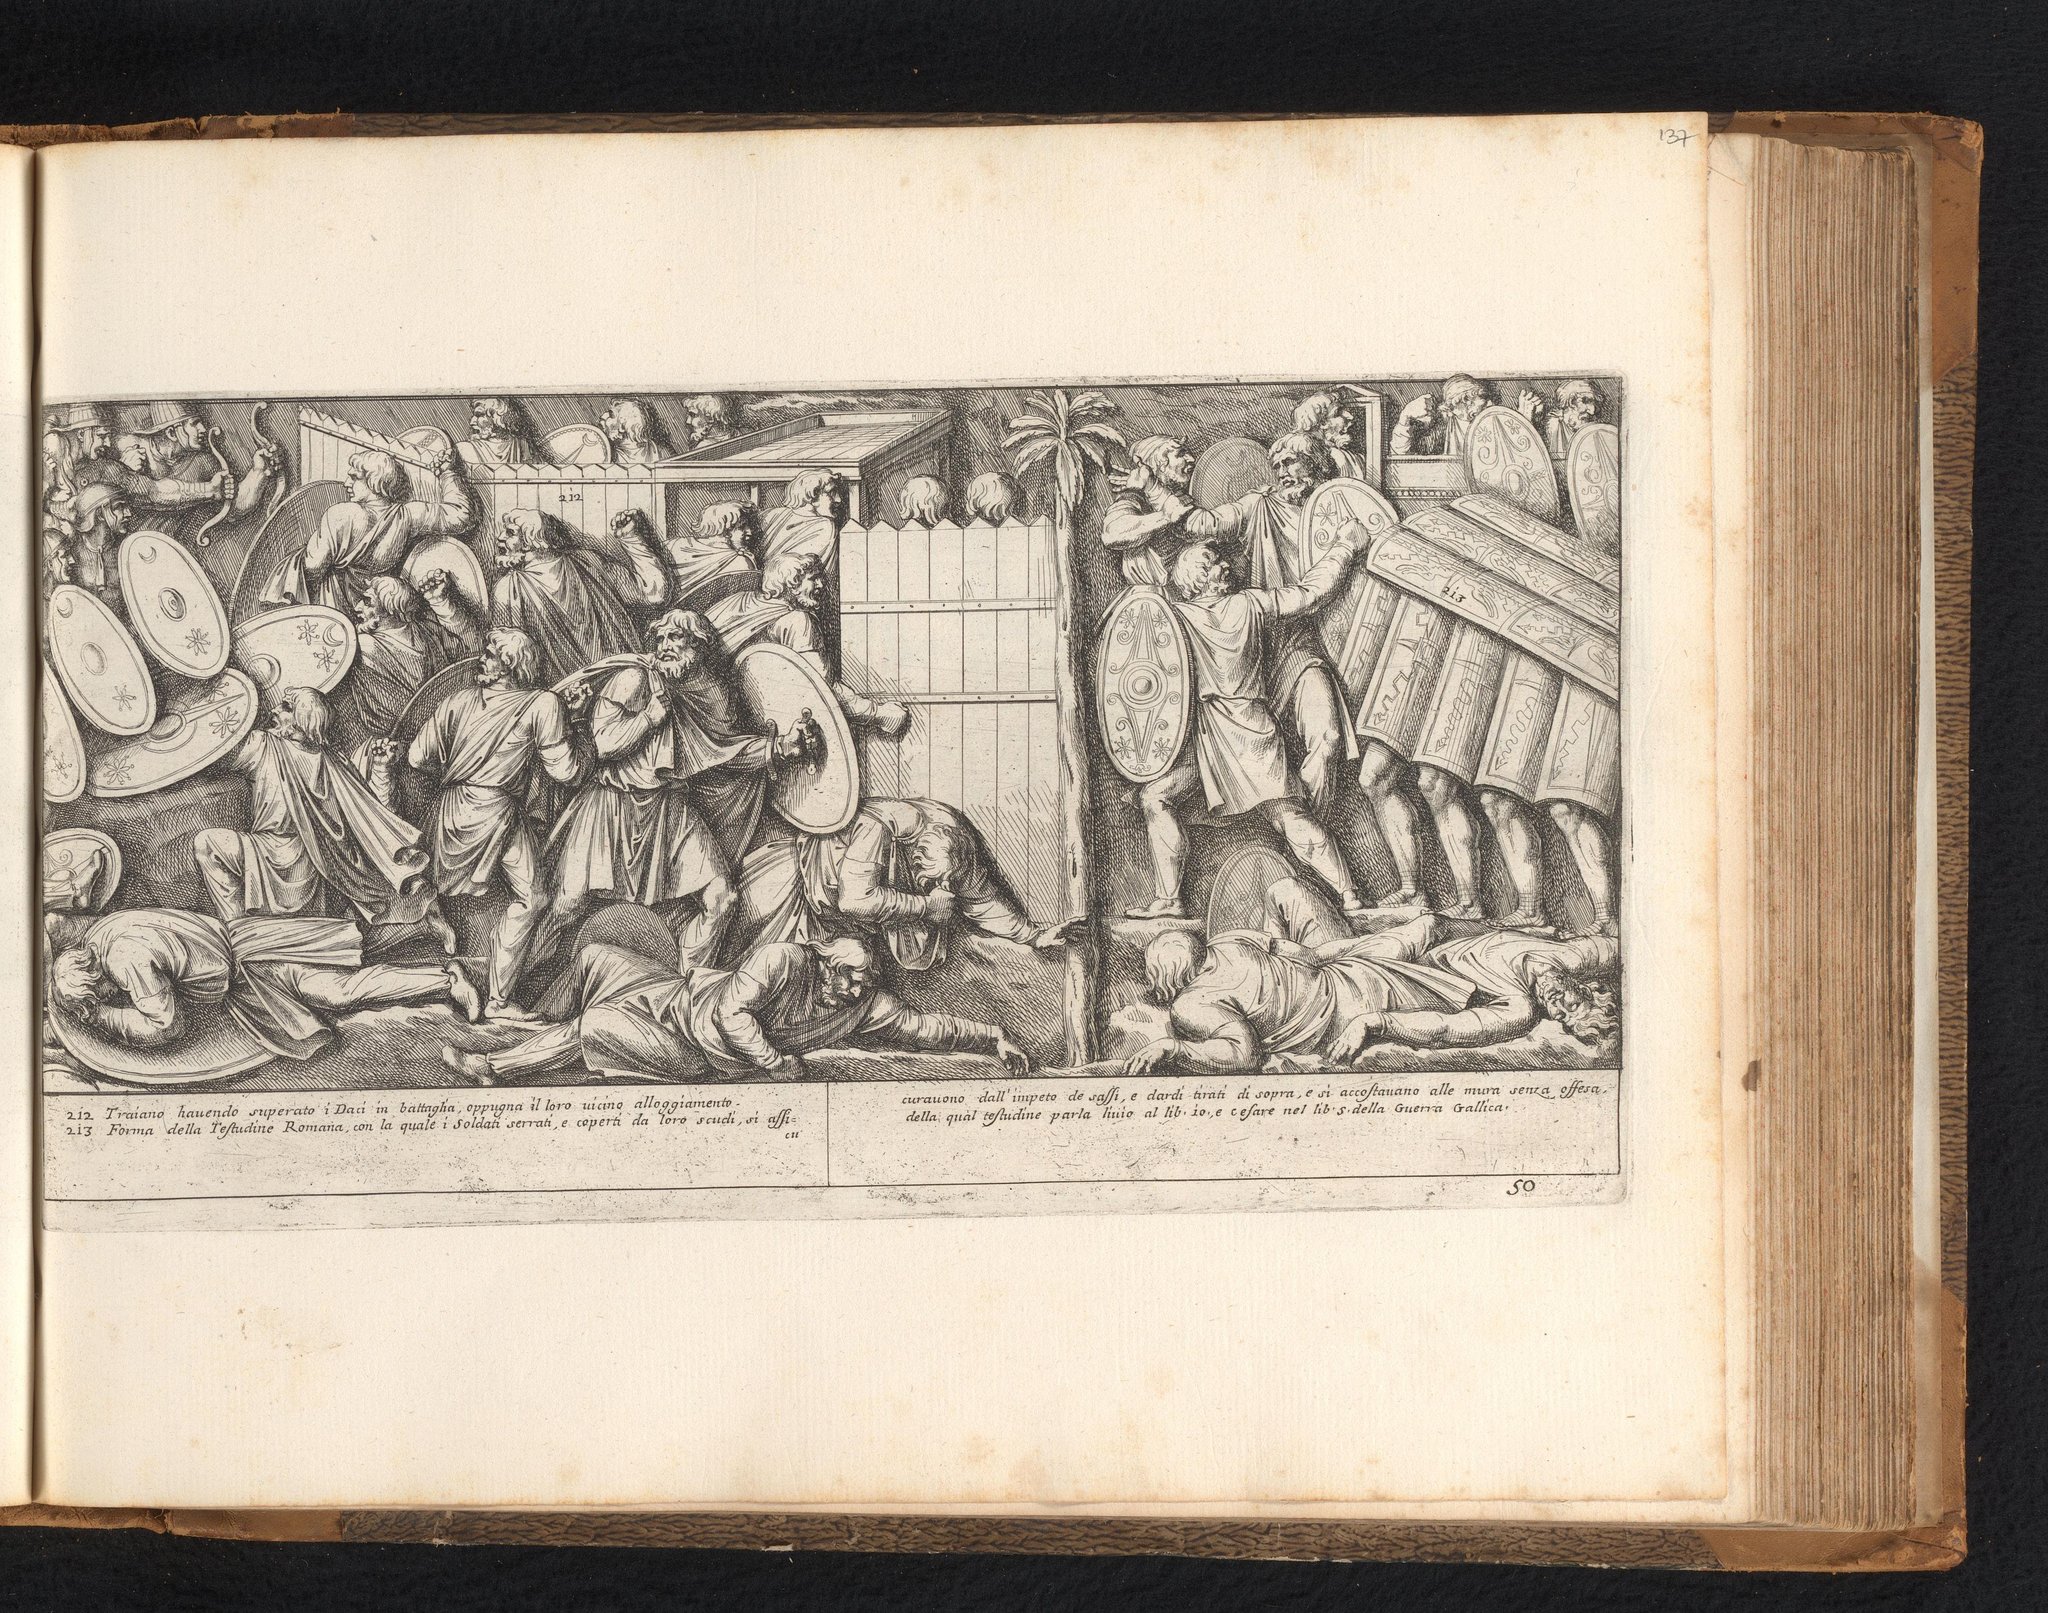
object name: album leaf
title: Detail van het fries op de Zuil van Trajanus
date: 1637-1691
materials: paper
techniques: etching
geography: vatican city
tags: triumphal column with helical friezes, piece of sculpture, reproduction of a piece of sculpture, the soldier; the soldier's life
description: Detail van het spiraalvormige gebeeldhouwde fries op de Zuil van Trajanus. Het fries toont de oorlogen tussen de Romeinen en de Daciërs. Verklarende nummers in de ondermarge. Prent maakt deel uit van een album.